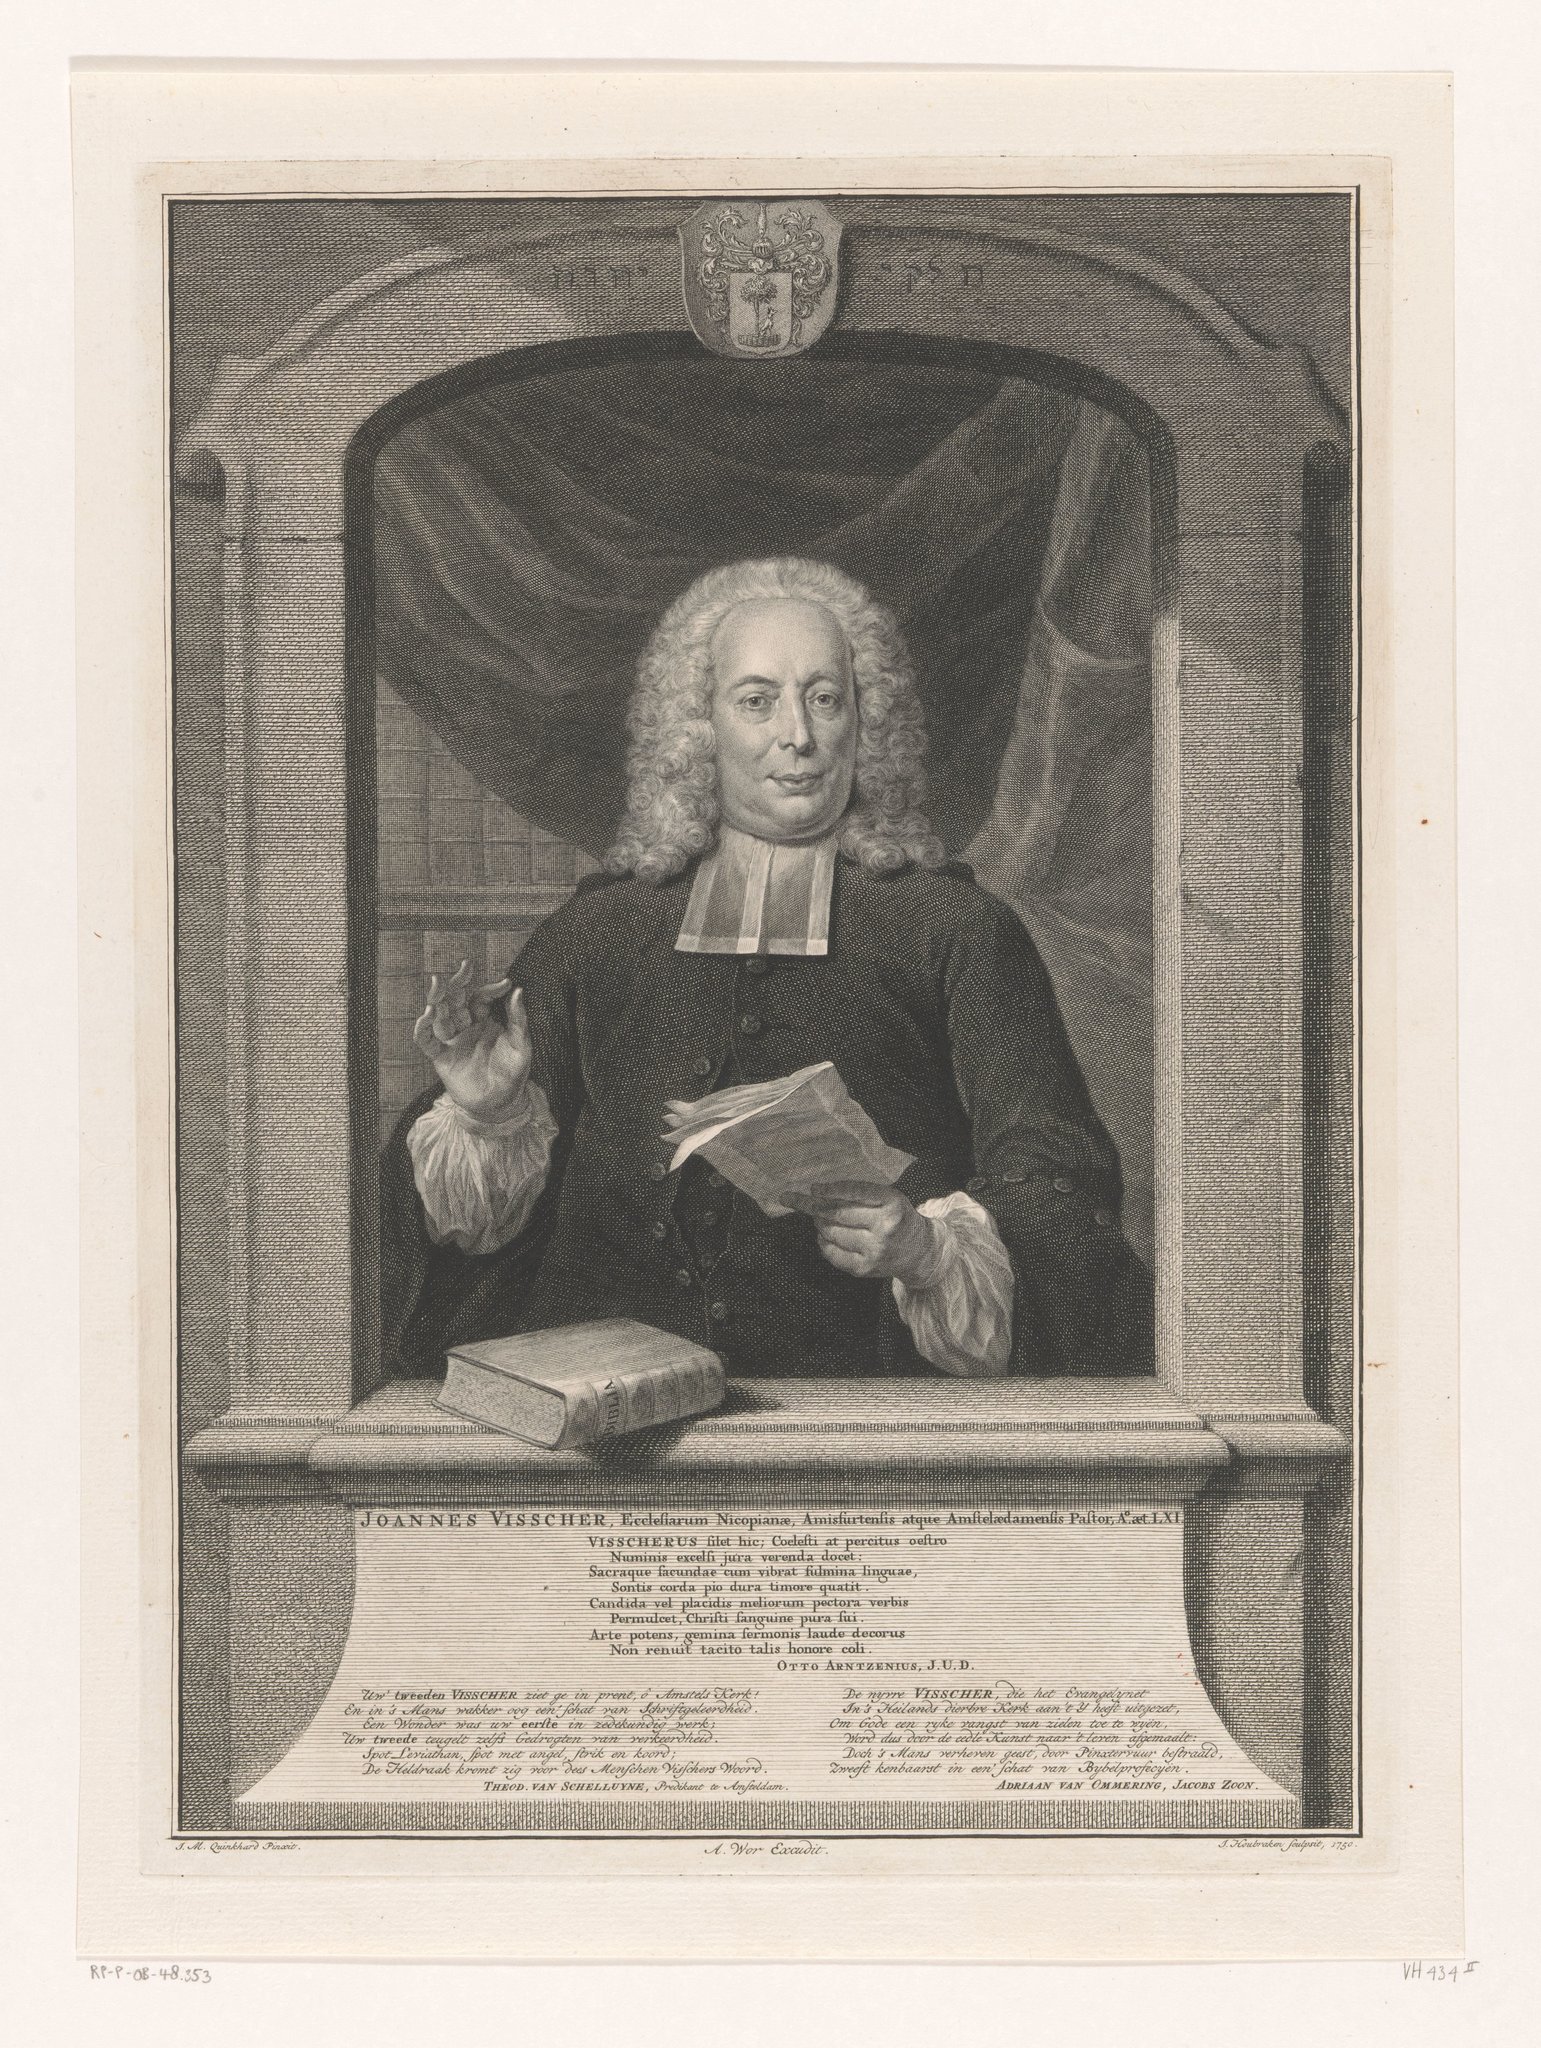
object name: print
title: Portret van Johannes Visscher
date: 1750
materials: paper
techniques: engraving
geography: amsterdam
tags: adult man, historical persons, book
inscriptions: collector's mark: Lugt 240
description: Portret ten halven lijve van Johannes Visscher op 61-jarige leeftijd in een venstervormige omlijsting. Voor hem op de vensterbank een bijbel en in zijn linkerhand een papier. Bovenaan zijn familiewapen en een regel in het Hebreeuws. Onder de vensterbank zijn naam en gegevens in een regel in het Latijn. Daaronder een achtregelig vers in het Latijn en twee, naast elkaar geplaatste, verzen met elk zes regels in het Nederlands.